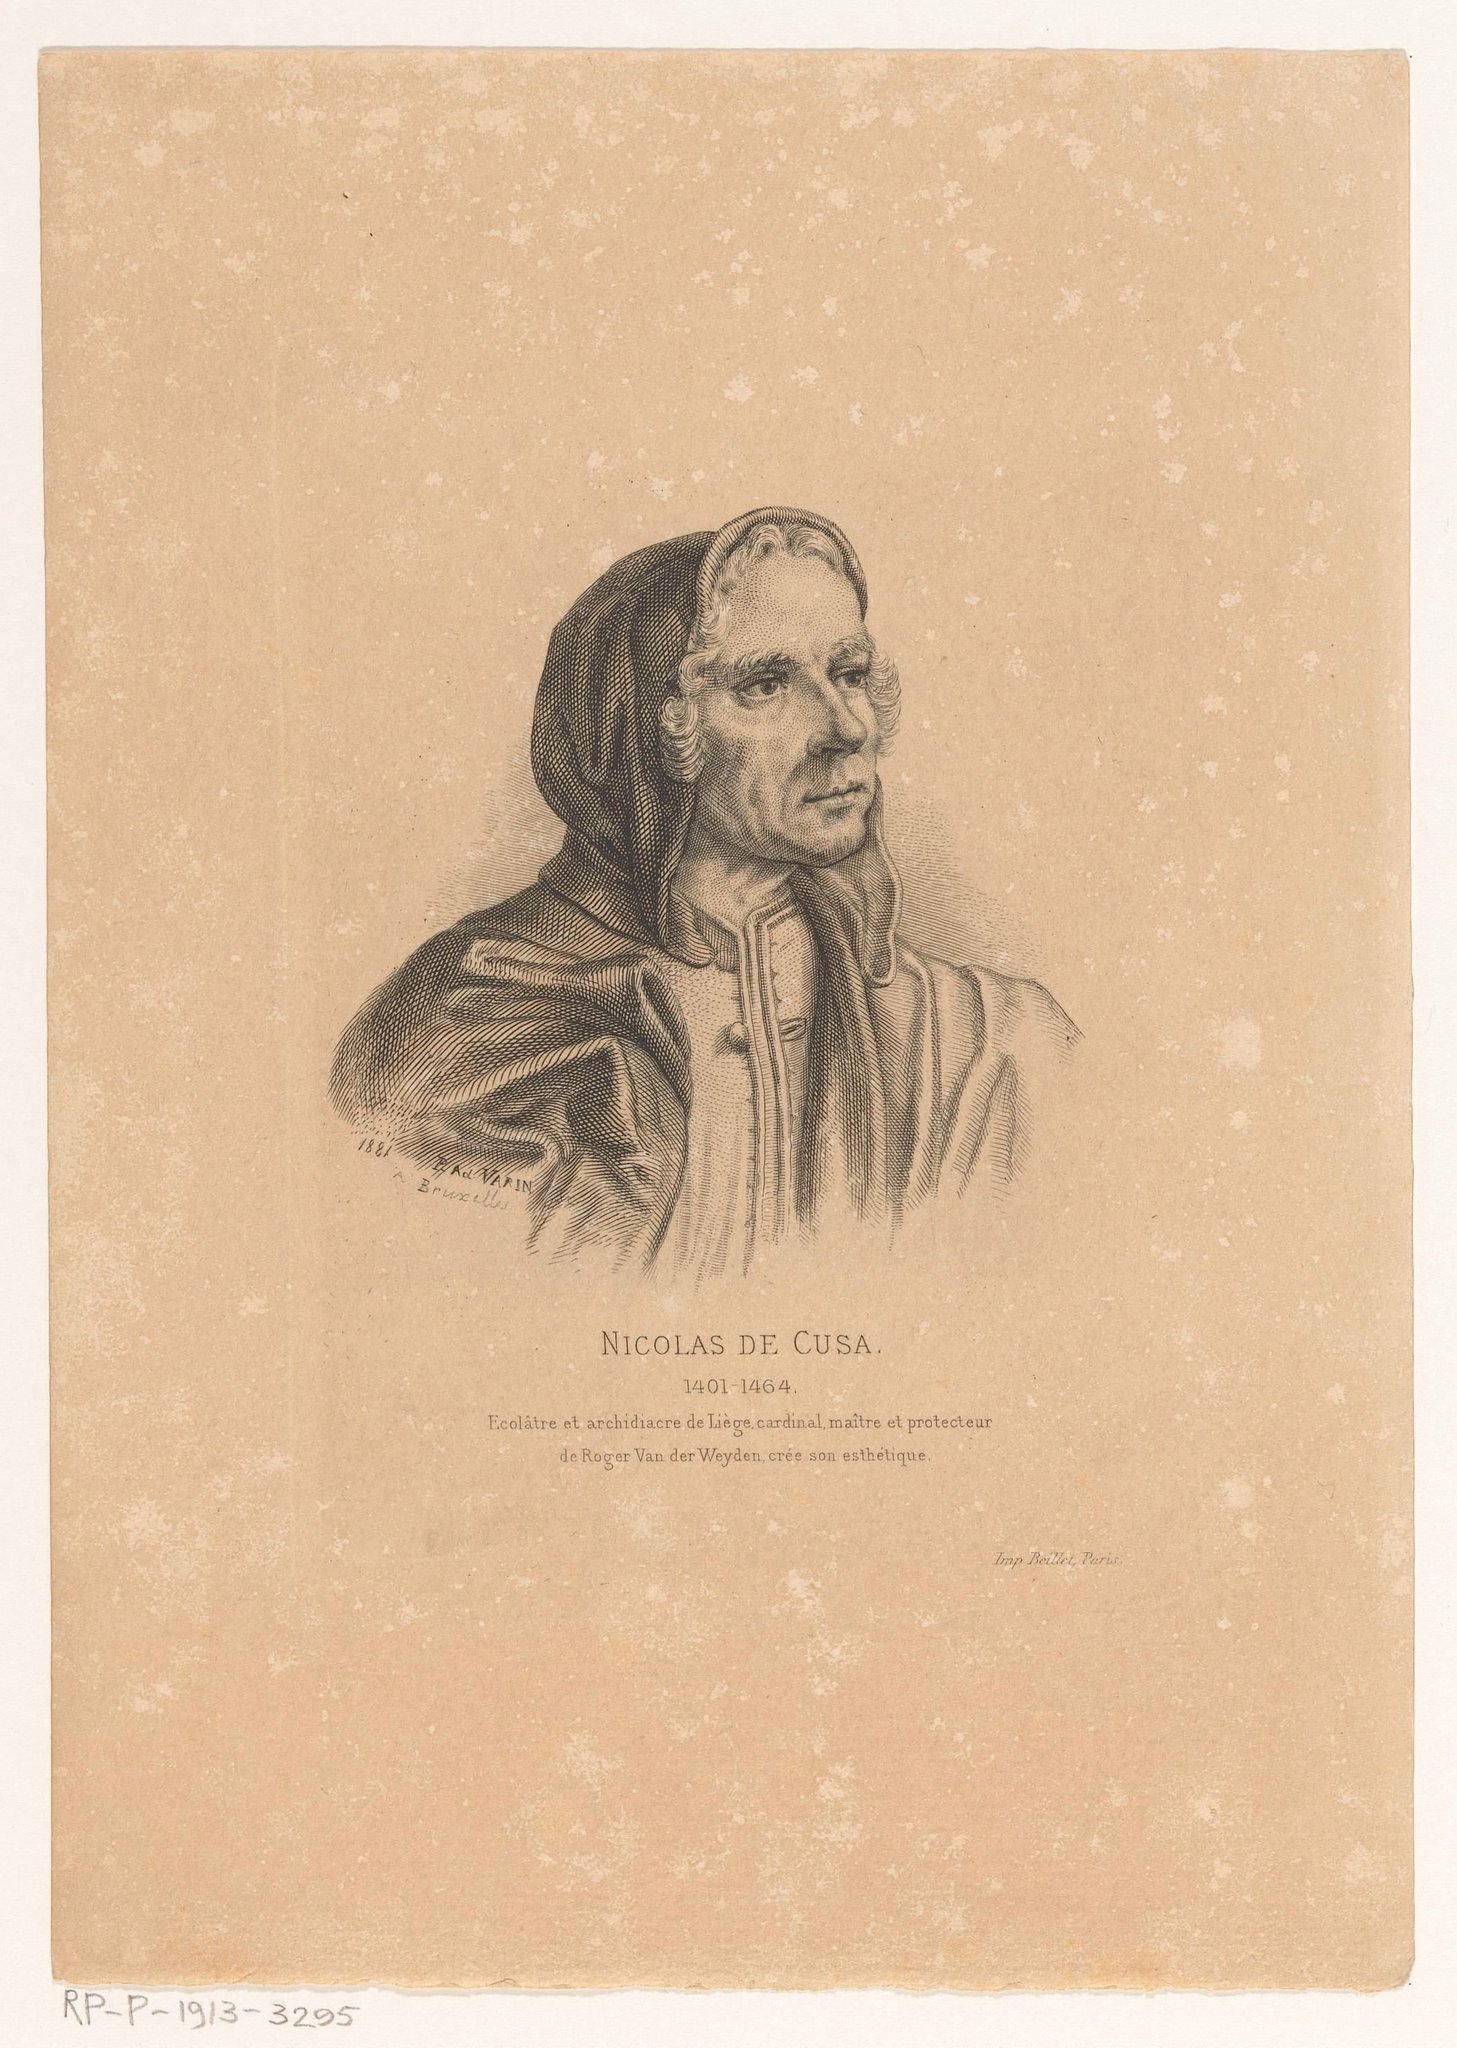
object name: print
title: Nicolas De Cusa.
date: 1881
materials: paper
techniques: engraving, etching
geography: brussels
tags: cardinal, historical persons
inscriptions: collector's mark: Lugt 2228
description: Prent uit: École liégeoise. Les Graveurs. Leurs portraits, reproduits au burin, d'après les originaux, par Adolphe Varin, 1366-1850. Avec notes historiques (...). Parijs: Fr. Gobbaerts, ca. 1684.